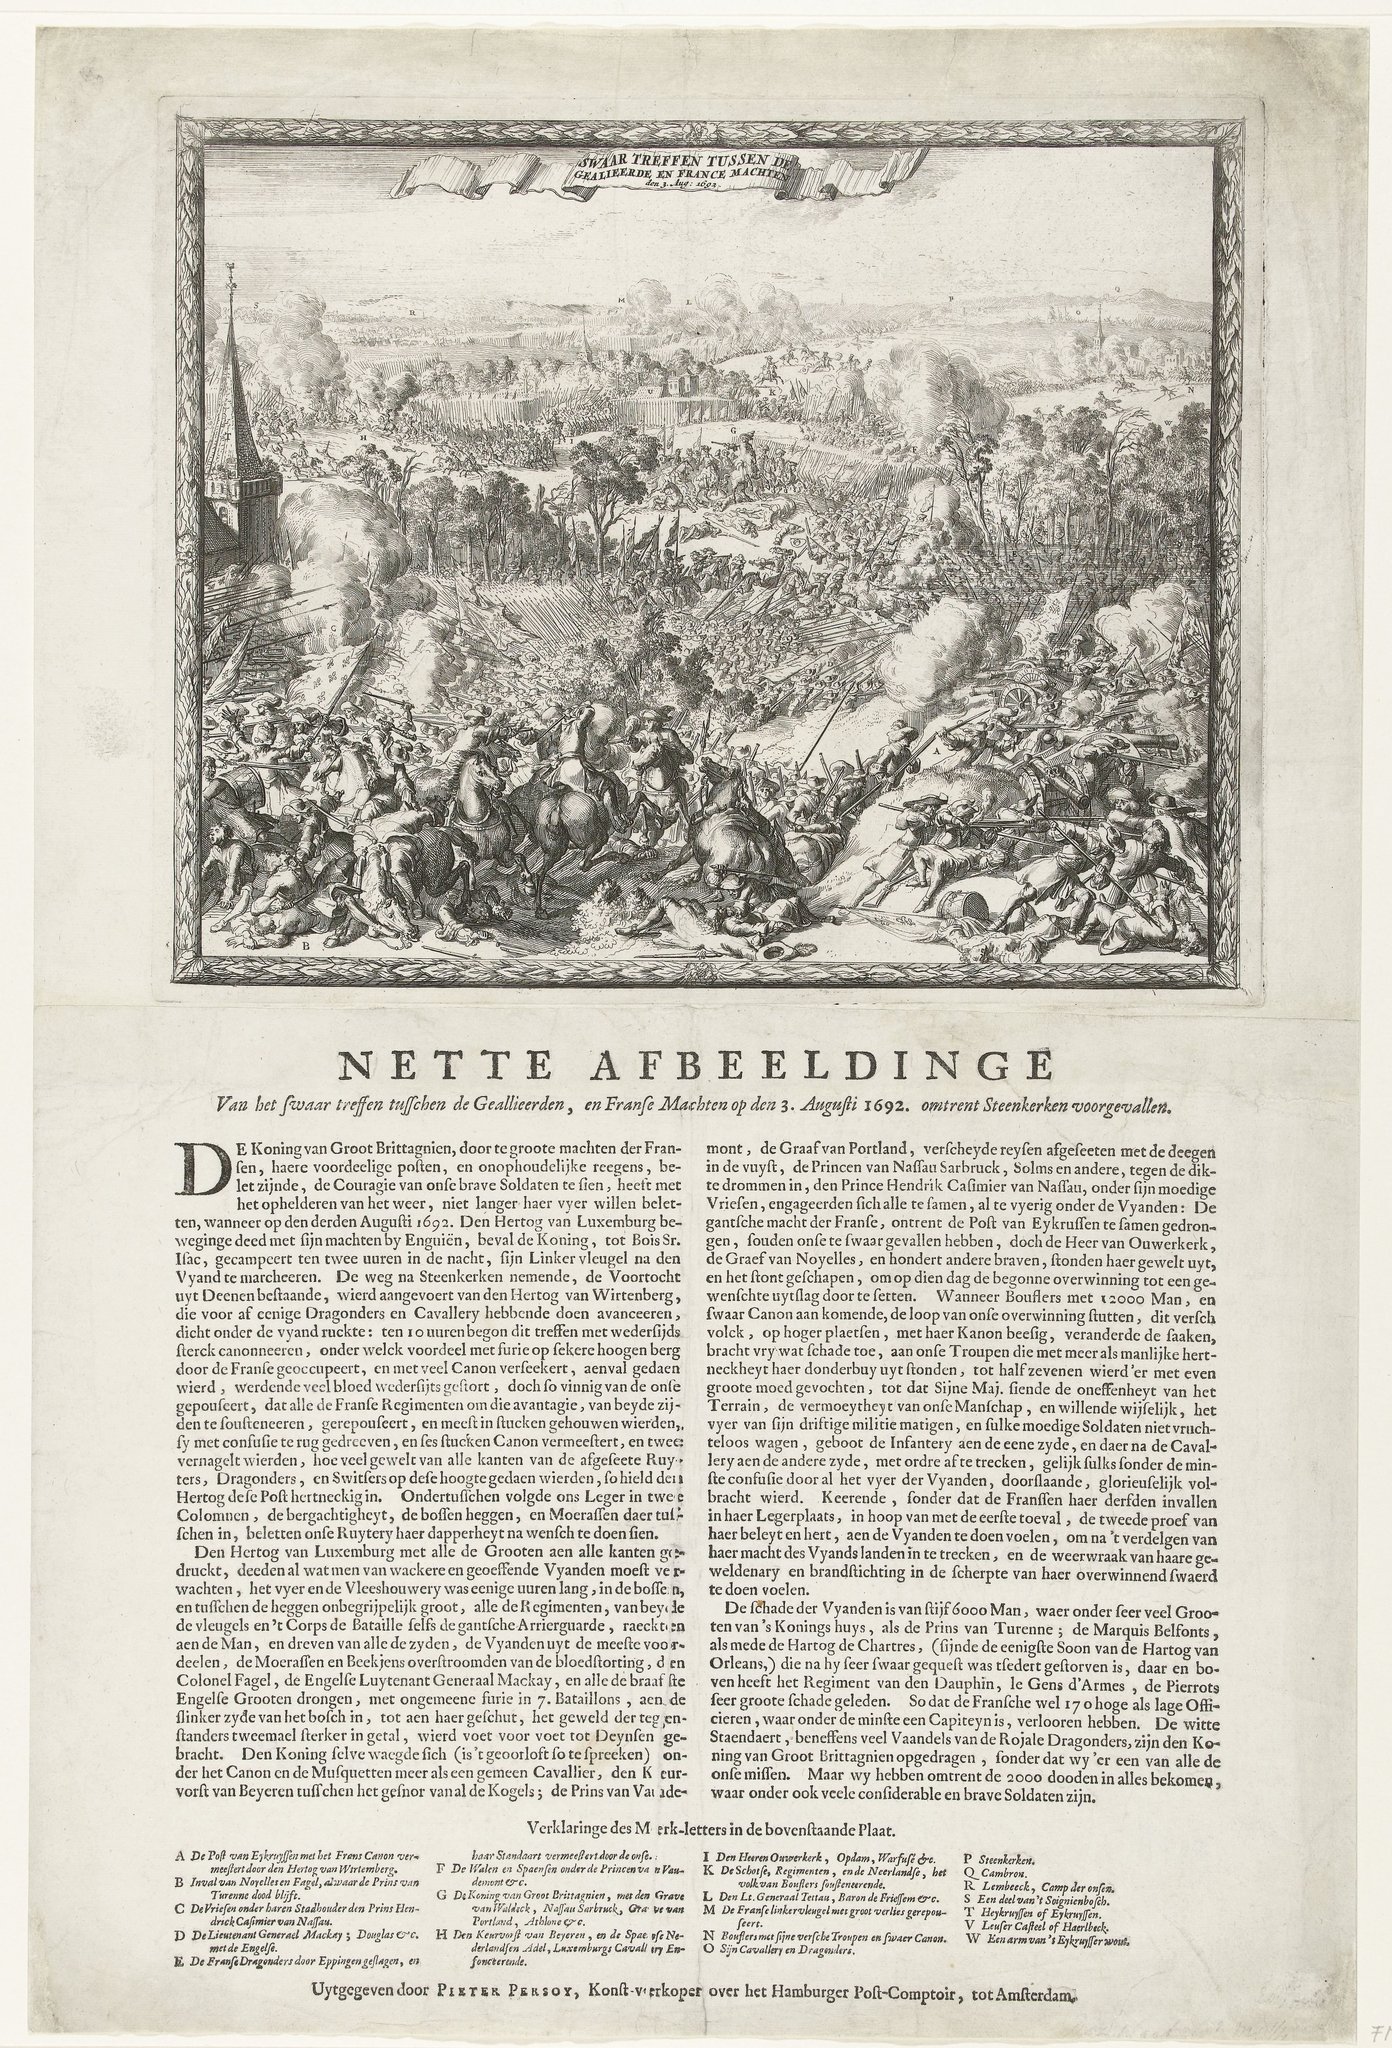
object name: print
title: Slag bij Steenkerke, 1692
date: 1692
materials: paper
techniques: etching, letterpress printing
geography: northern netherlands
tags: battle (+ land forces)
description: Slag bij Steenkerke in Henegouwen waarbij het Franse leger onder de duc de Luxembourg de geallieerden onder koning Willem III versloeg, 3 augustus 1692. Op een blad geplakt onder de prent een beschrijving van de veldslag in twee kolommen met de legenda A-W.